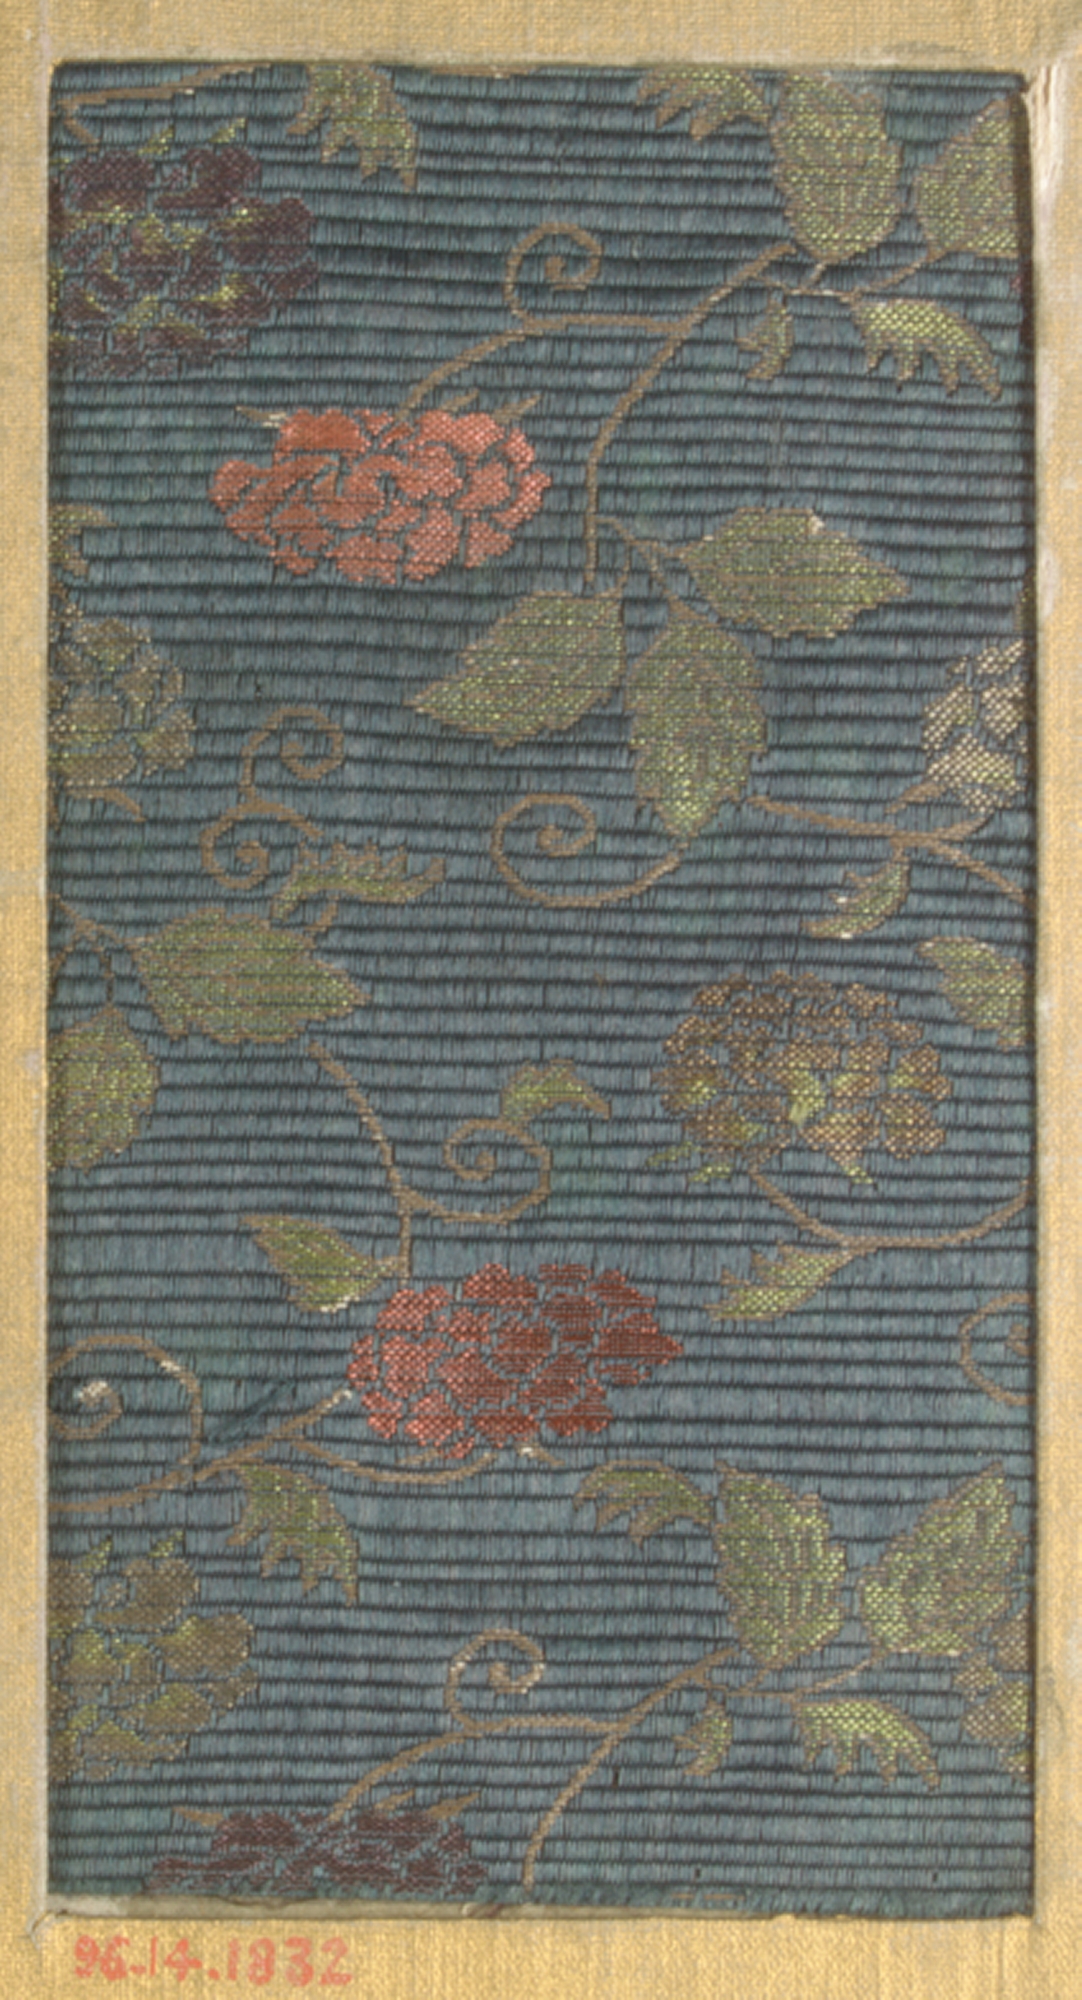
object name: piece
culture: japanese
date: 1701-1900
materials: silk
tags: leaves